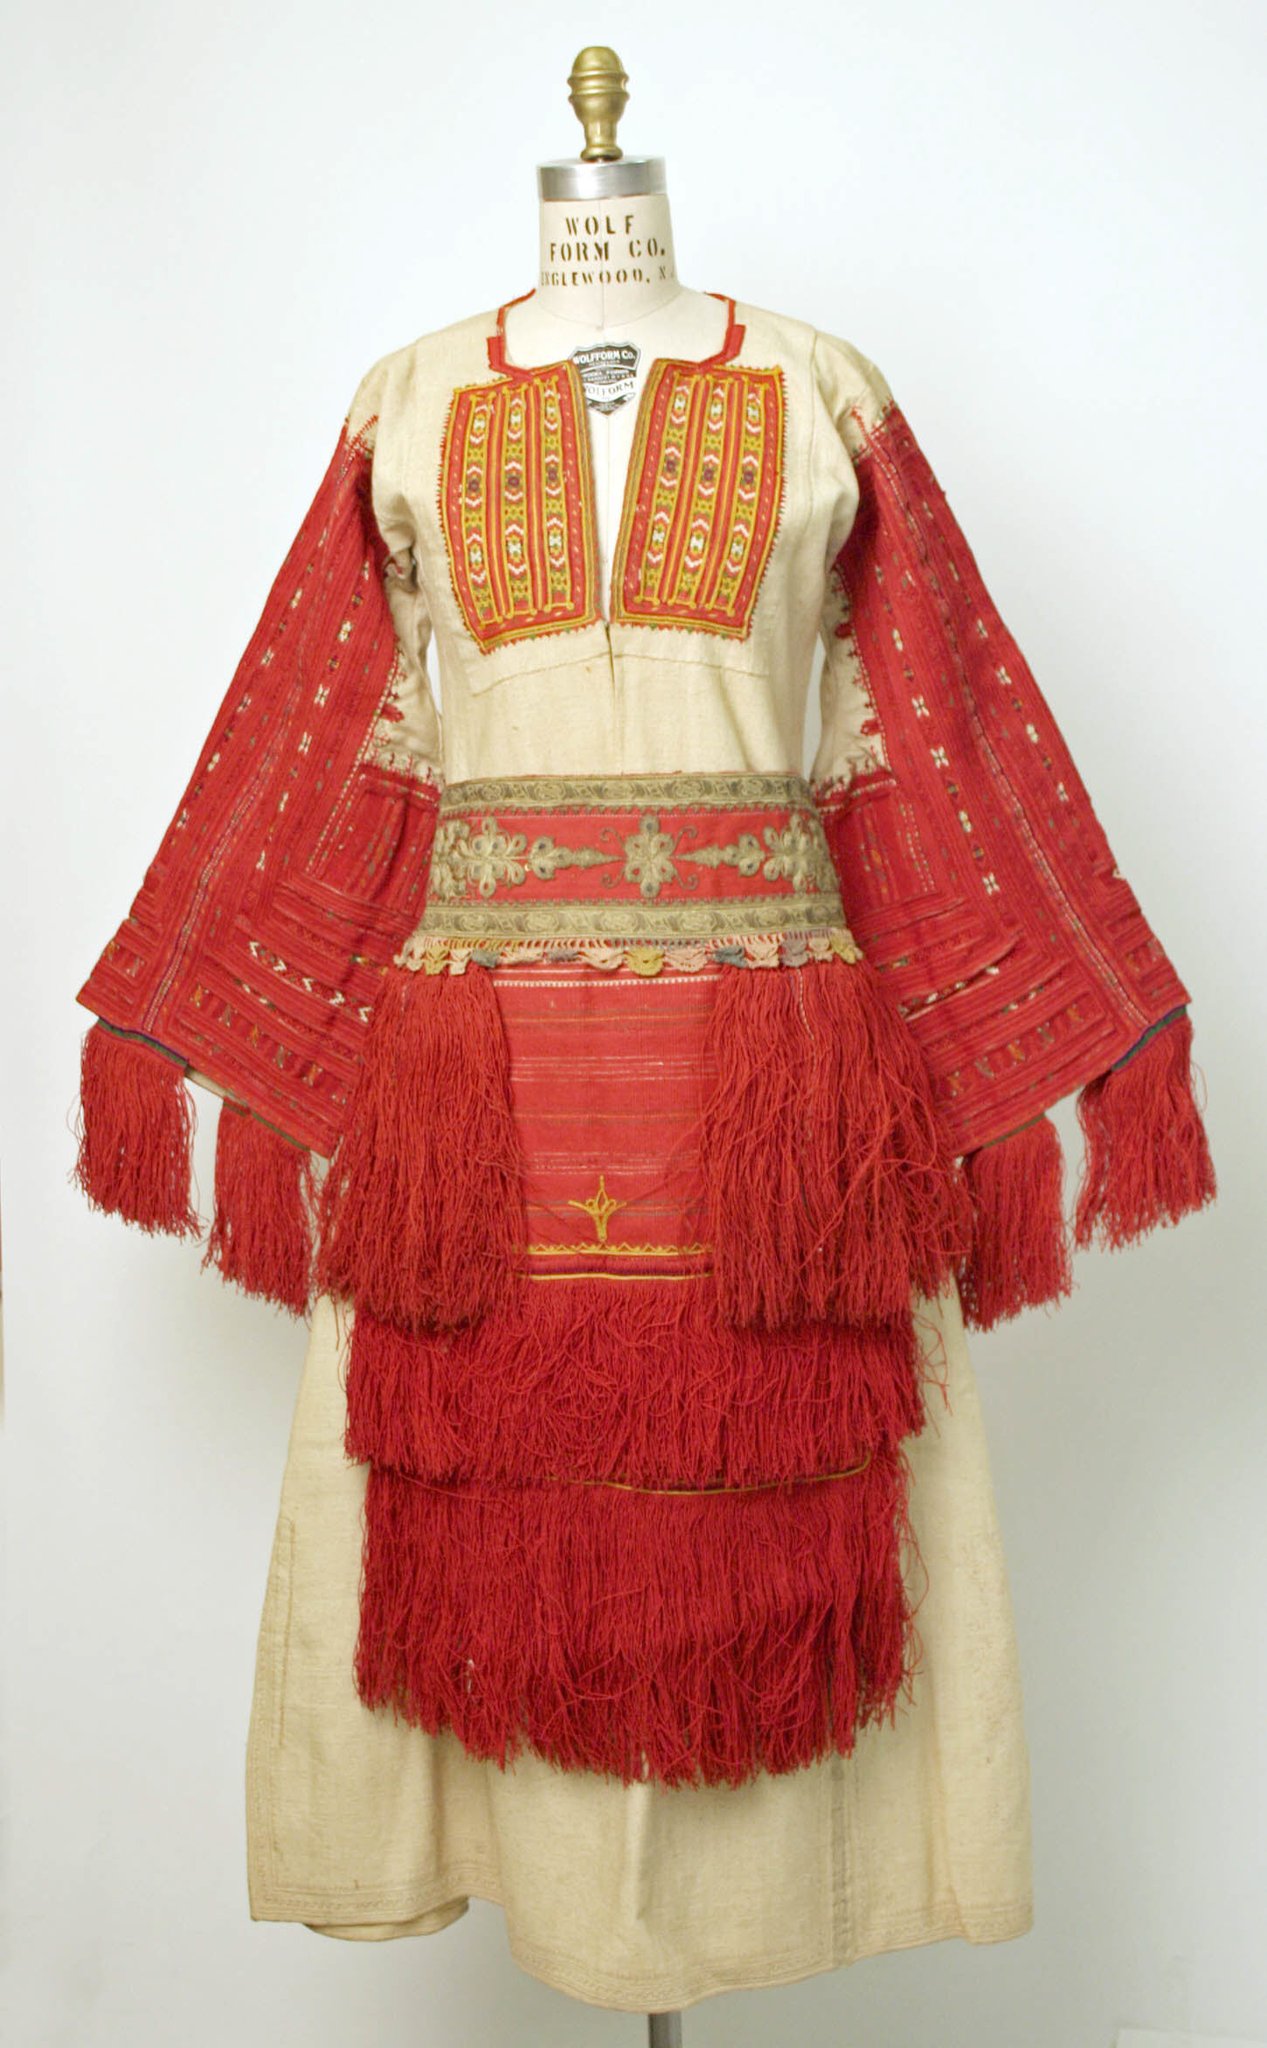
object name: ensemble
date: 1867-1900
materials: cotton, wood, wool